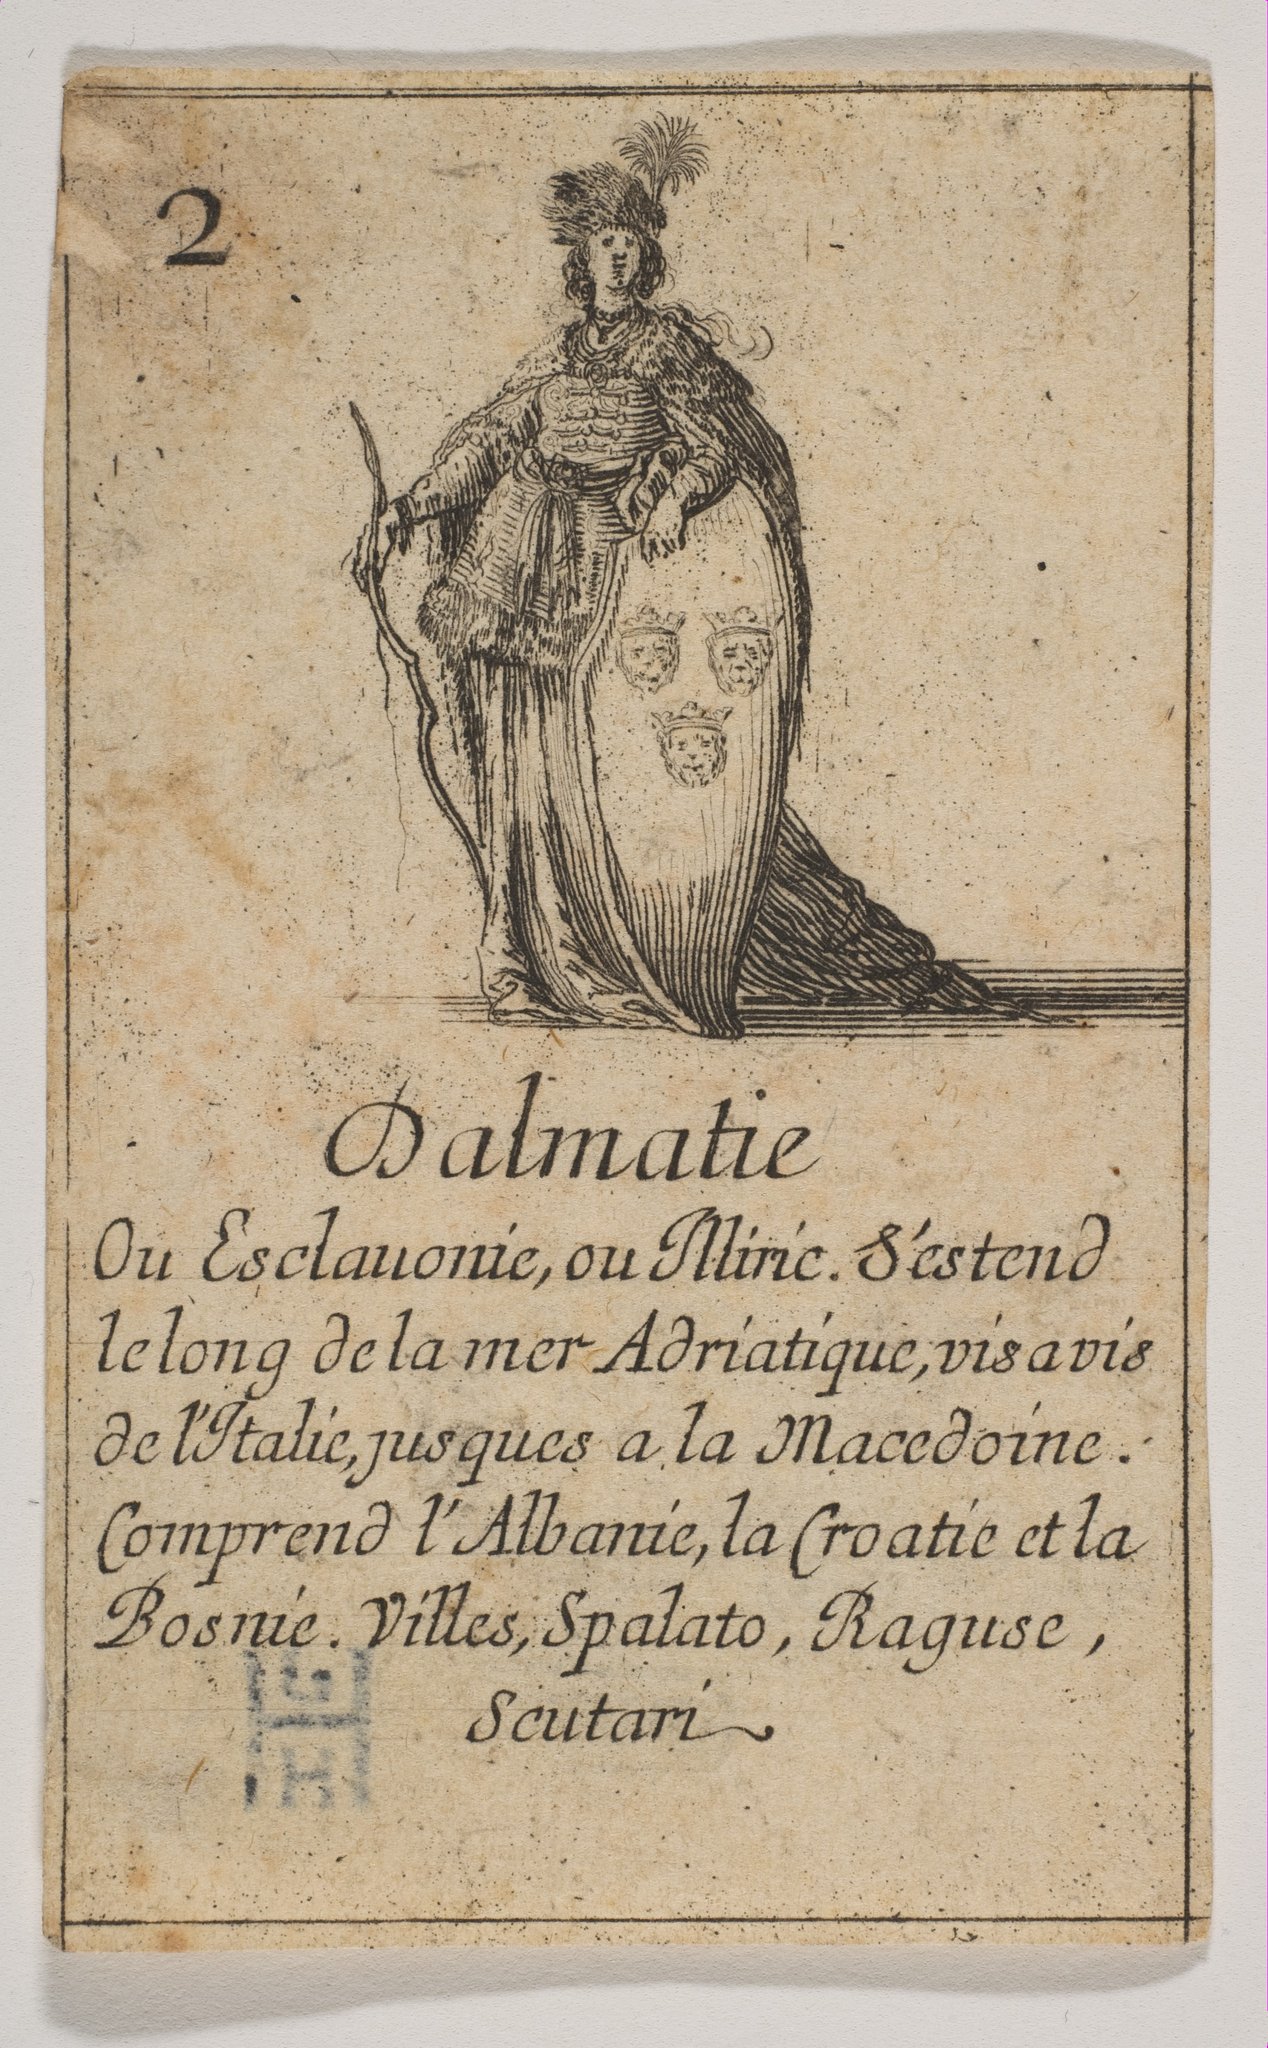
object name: print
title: Dalmatie, from "Jeu de la Géographie"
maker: stefano della bella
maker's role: artist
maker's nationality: italian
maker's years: 1610-1664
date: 1644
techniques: etching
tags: shields,men